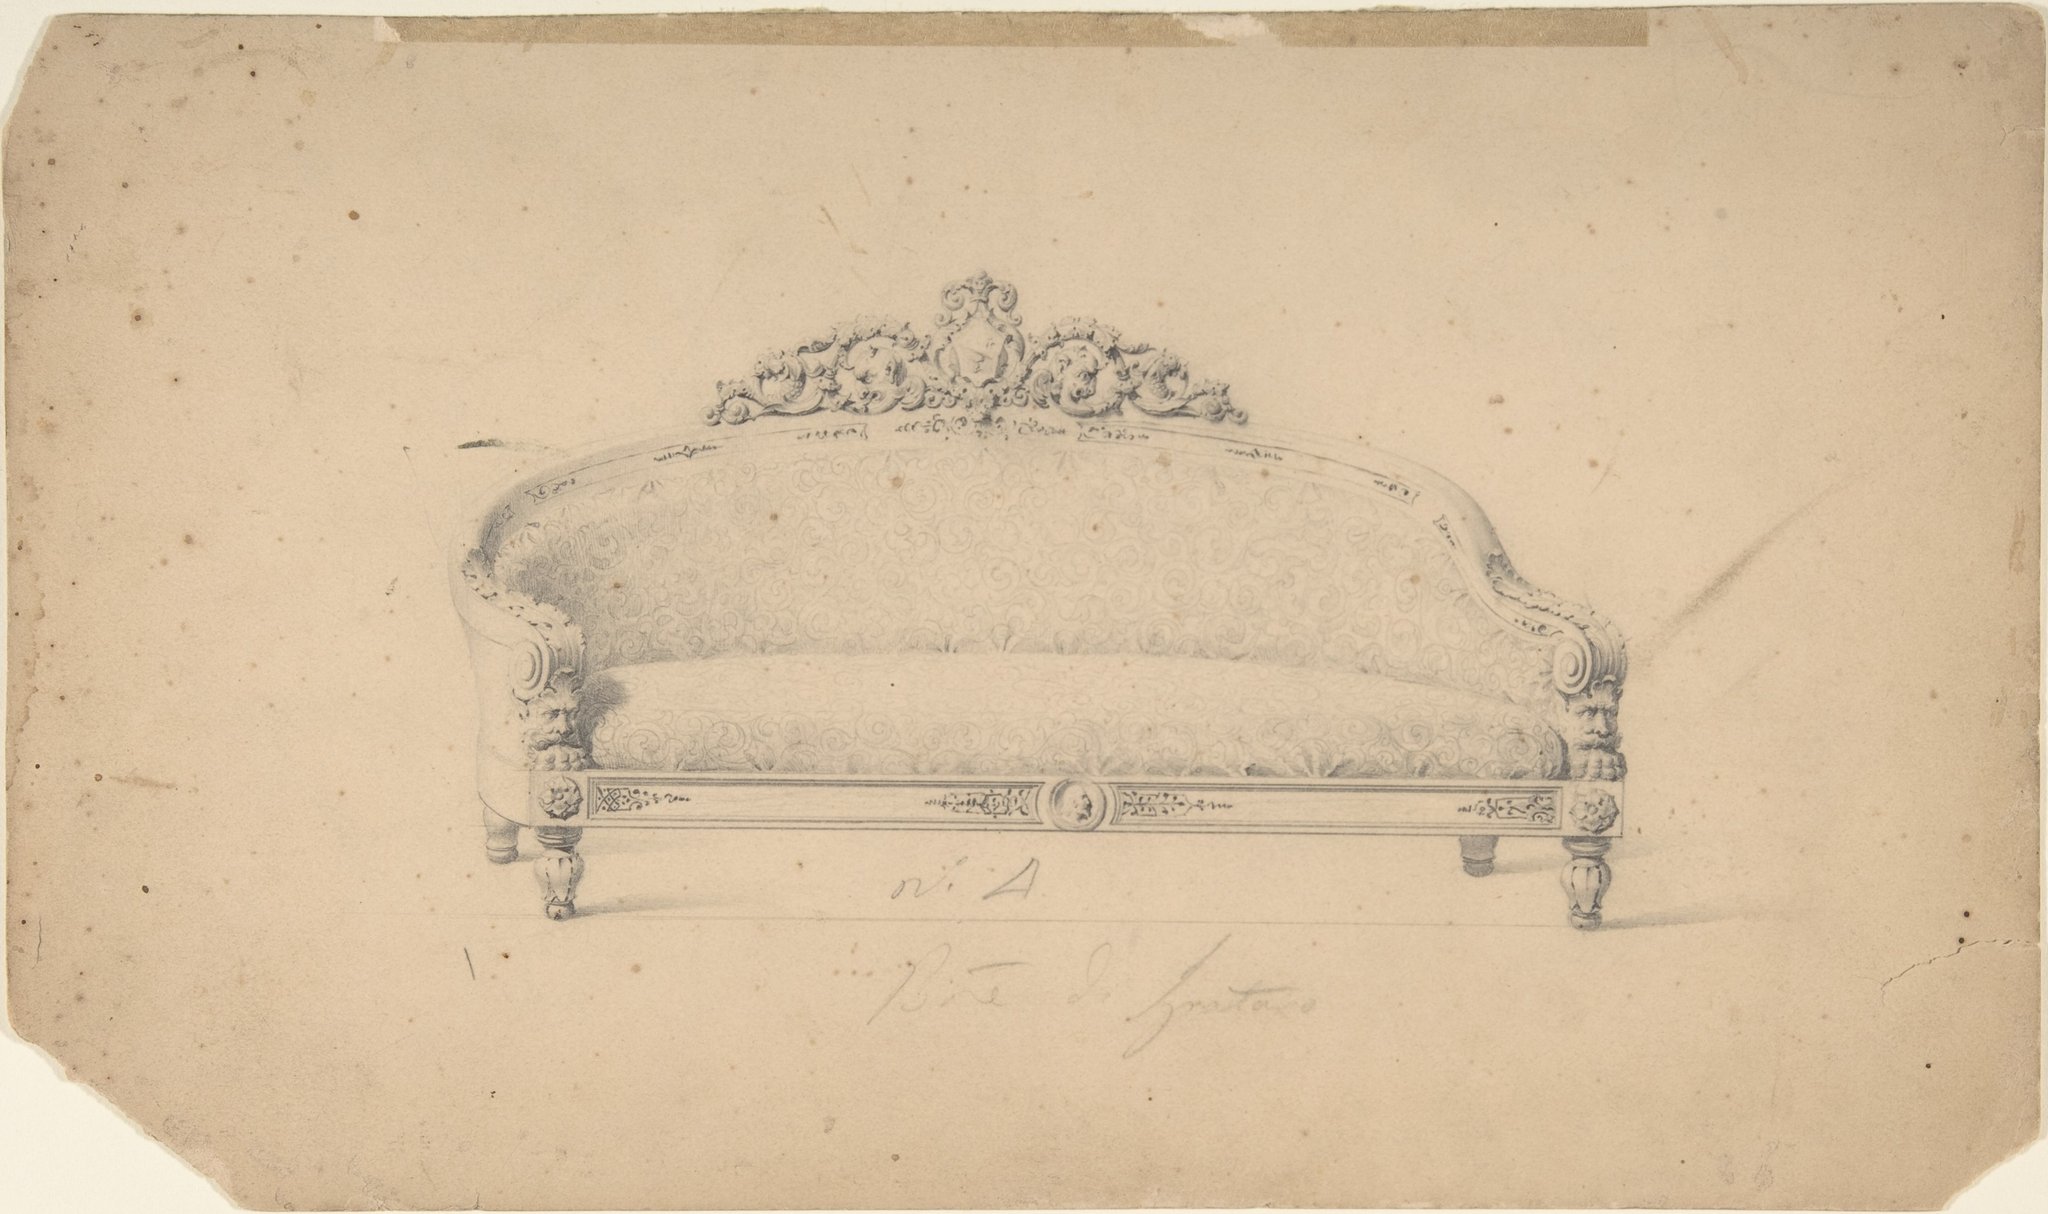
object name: drawing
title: Design for a Couch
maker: anonymous, italian, 19th century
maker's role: artist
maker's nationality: italian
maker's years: 1800-1900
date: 1800-1900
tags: couches